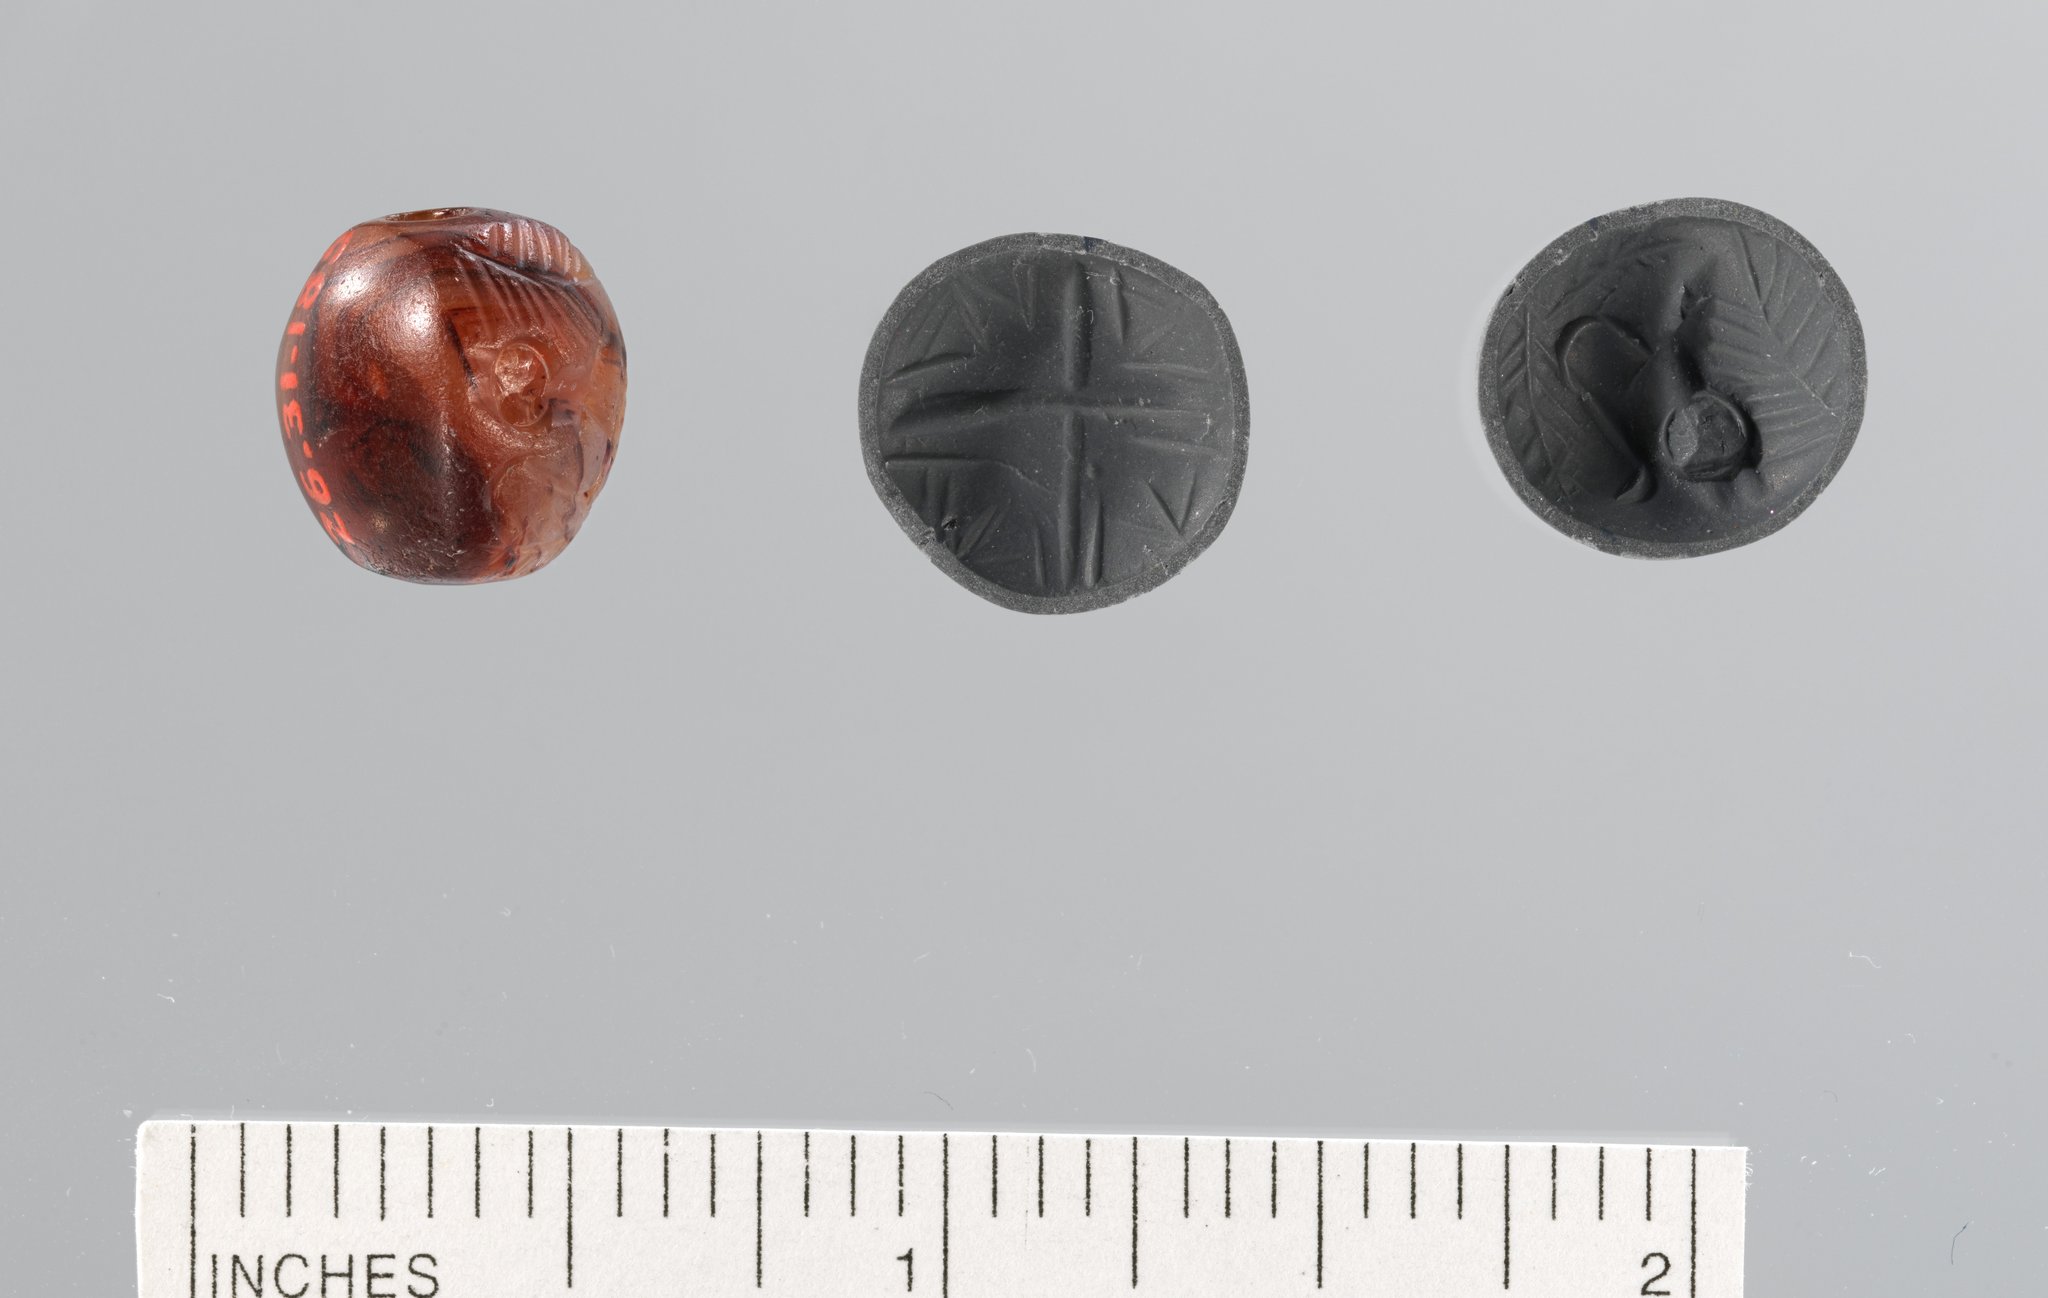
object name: prism, triangular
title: Agate Triangular Prism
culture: minoan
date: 1650-1500 BCE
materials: stone